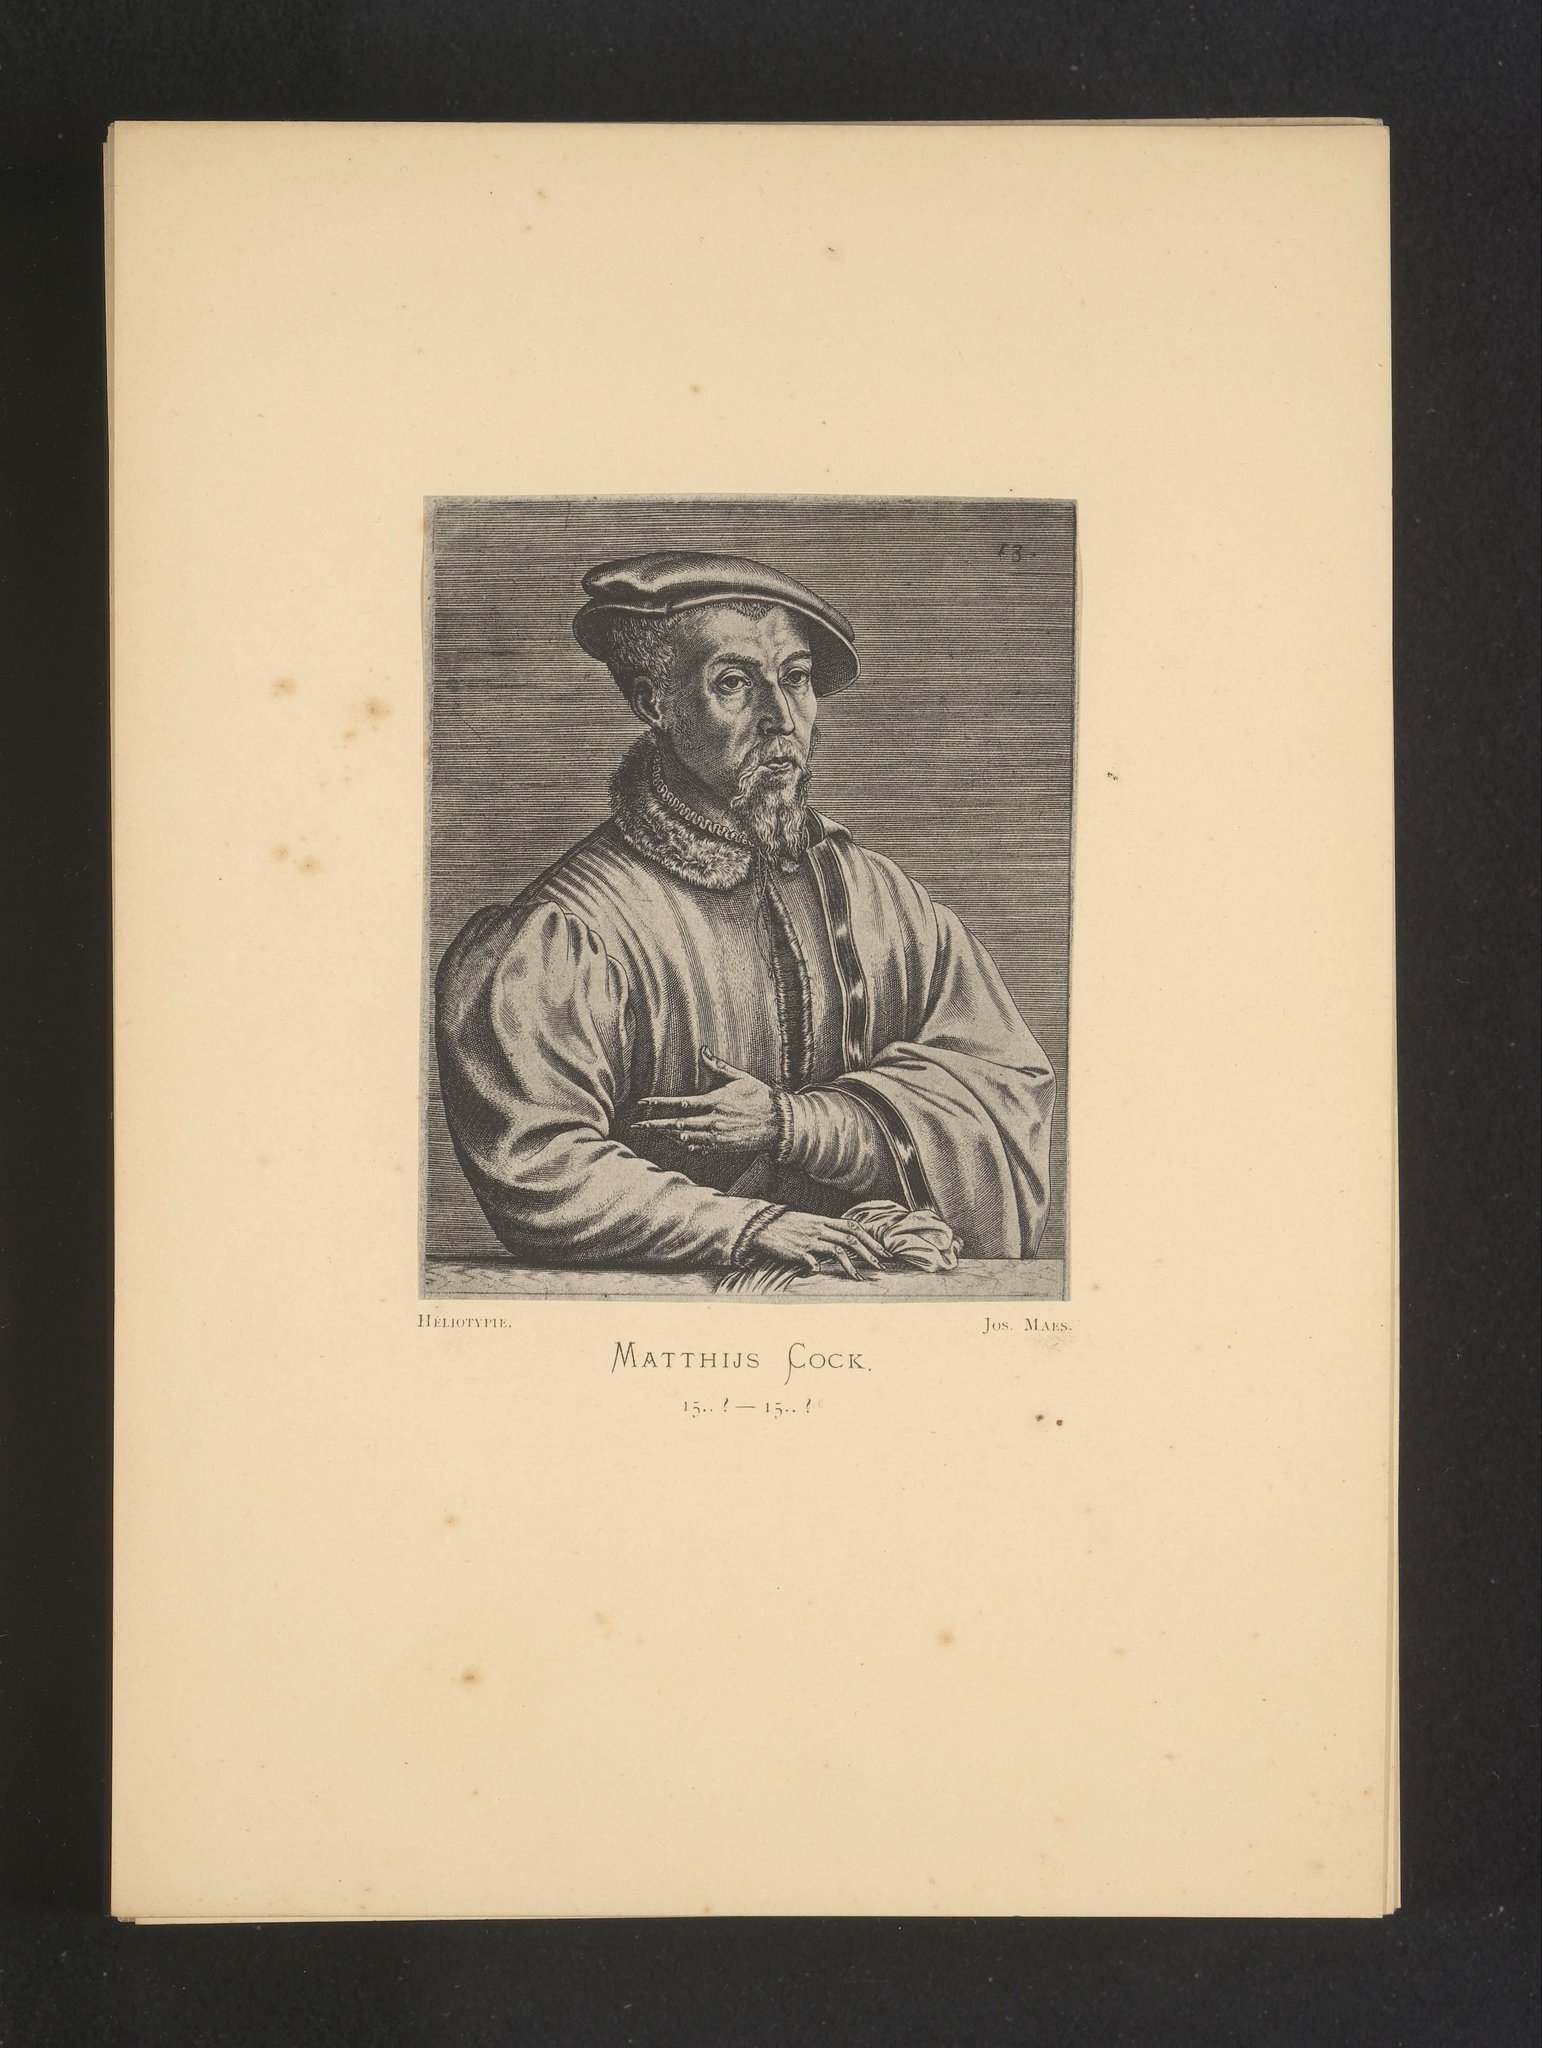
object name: reproduction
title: Reproductie van een gravure van een portret van Matthijs Cock door Johannes Wierix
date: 1872-1877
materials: cardboard, paper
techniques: photograph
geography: antwerp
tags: antwerp, draughtsman, matthys cock, historical persons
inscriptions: inscription: ‘15..? - 15..?’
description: Deze prent maakt deel uit van een omslag met 150 prenten en een katern met een lijst van afbeeldingen.